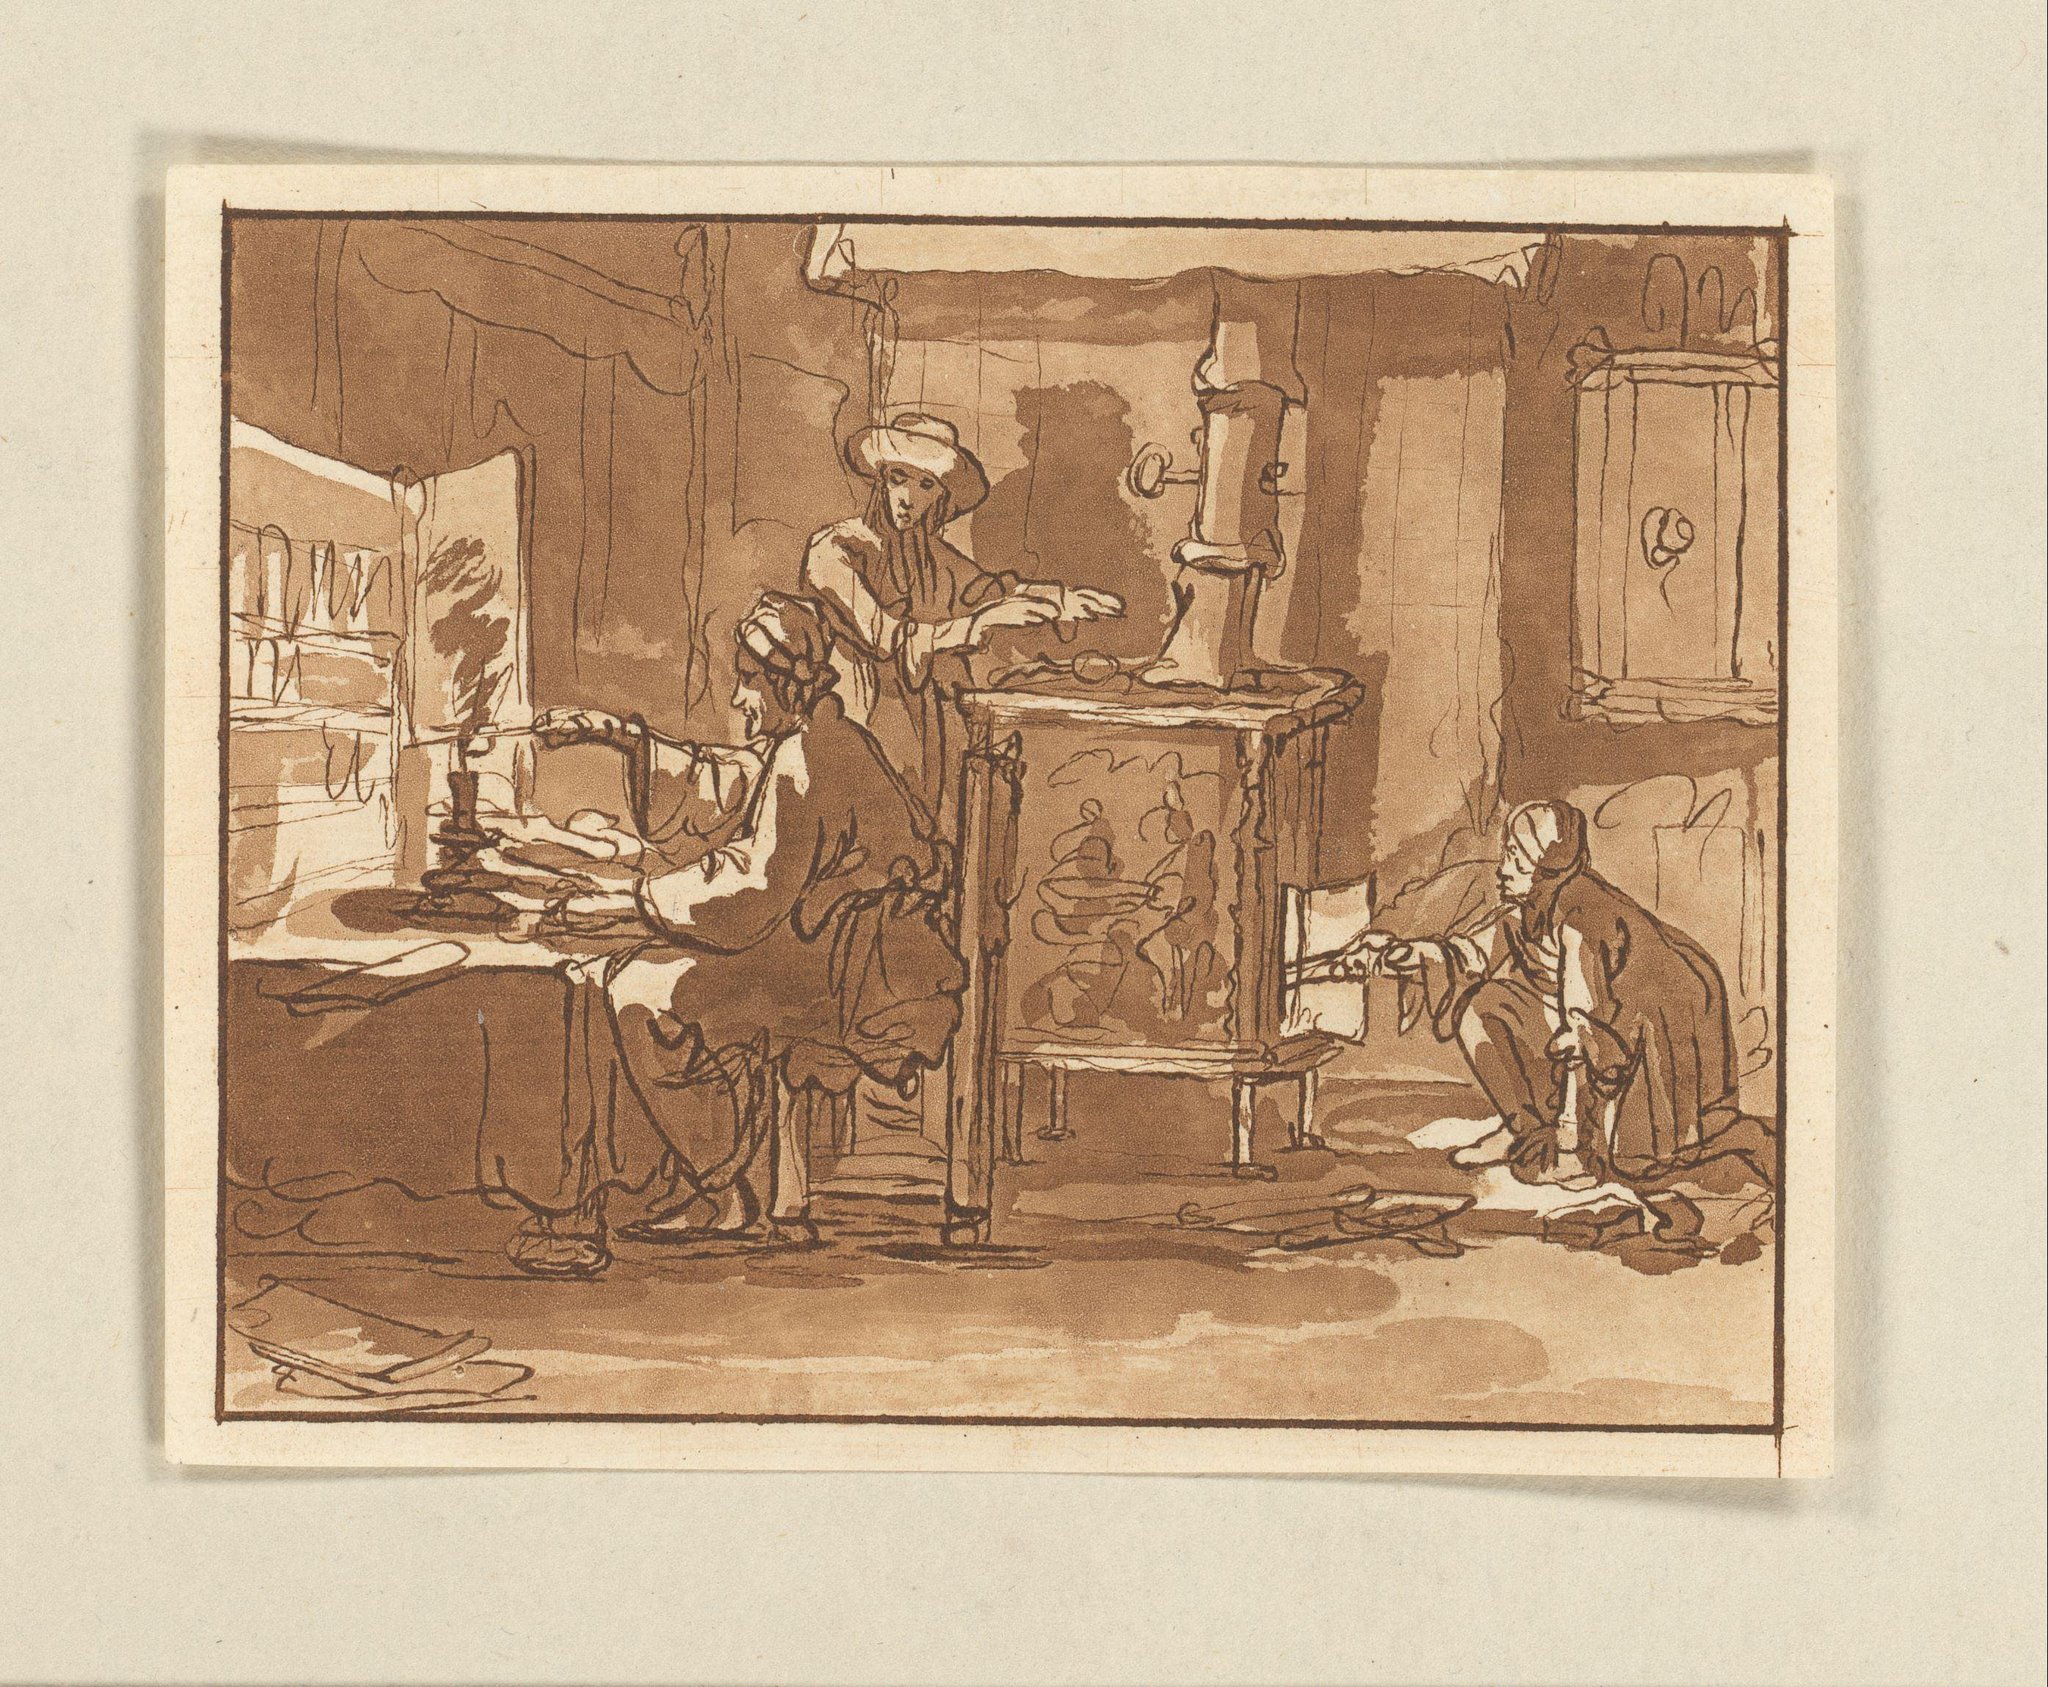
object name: print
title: Kaarssnuitende man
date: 1782-1787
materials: paper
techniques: transfer, print drawing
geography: amsterdam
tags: snuffers, warming oneself at a fire (or hearth, stove, fire-pan, brazier), heating stove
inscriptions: inscription: Lugt 2725, collector's mark: ‘RIJKS / MUSM’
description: Interieur met een zittende man, die een kaars dooft. Bij de kachel een staande man, die zijn handen warmt, en een ander die het vuur opstookt. De prent ligt los in een album, zie blad 45.